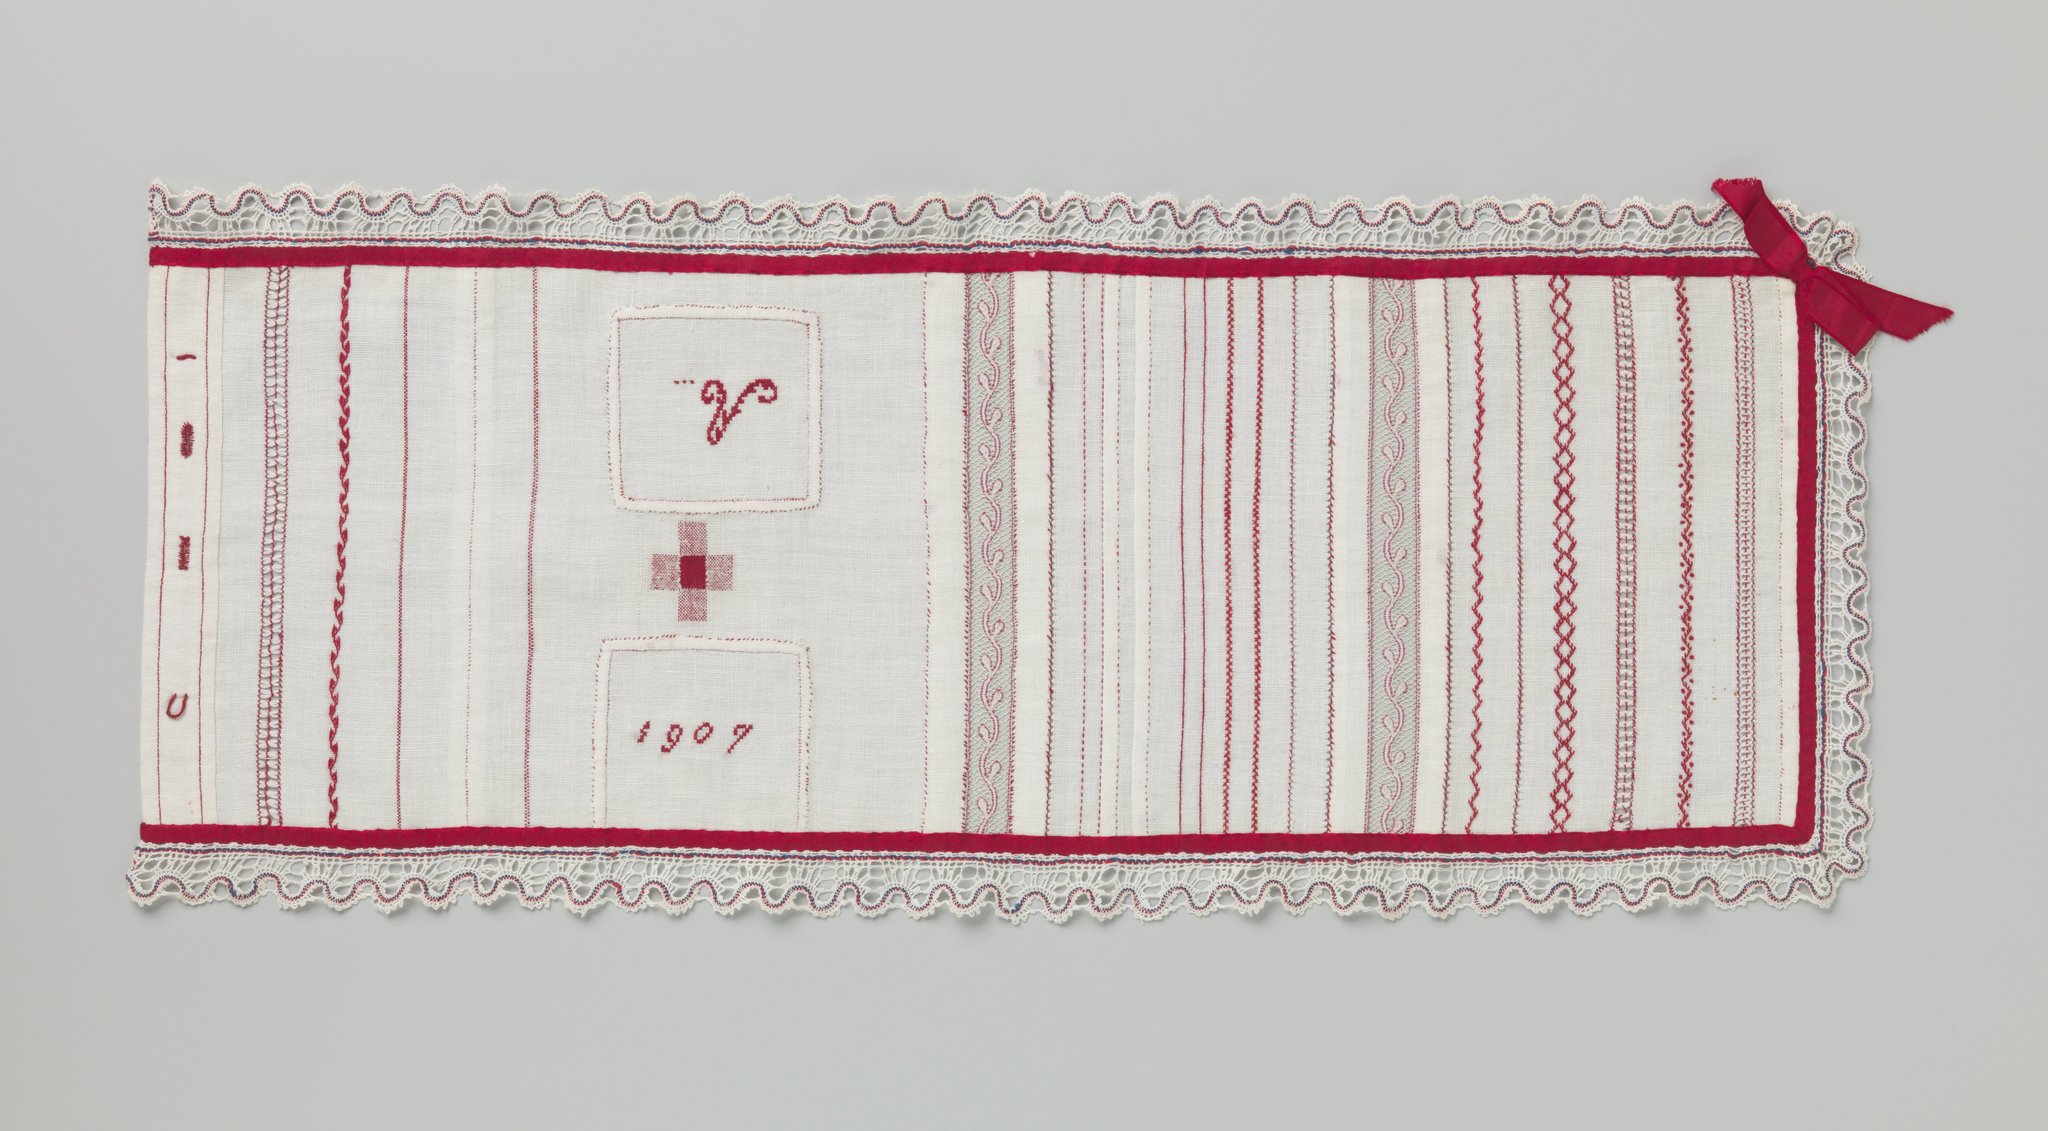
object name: naaiwerk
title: Merklap met een strook Valenciennes kant en Clunykant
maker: a.m. luns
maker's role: gemeenteraadslid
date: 1907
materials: silk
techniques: lace, embroidered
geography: brussels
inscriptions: date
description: Merklap met diverse steken en onderbrekingen van twee Valenciennes entre-deux en twee ingezette vierkante verstelstukken, waarin een A en 1907. De lap is afgewerkt met een rood lint, een hoekstrik en een Clunykant.